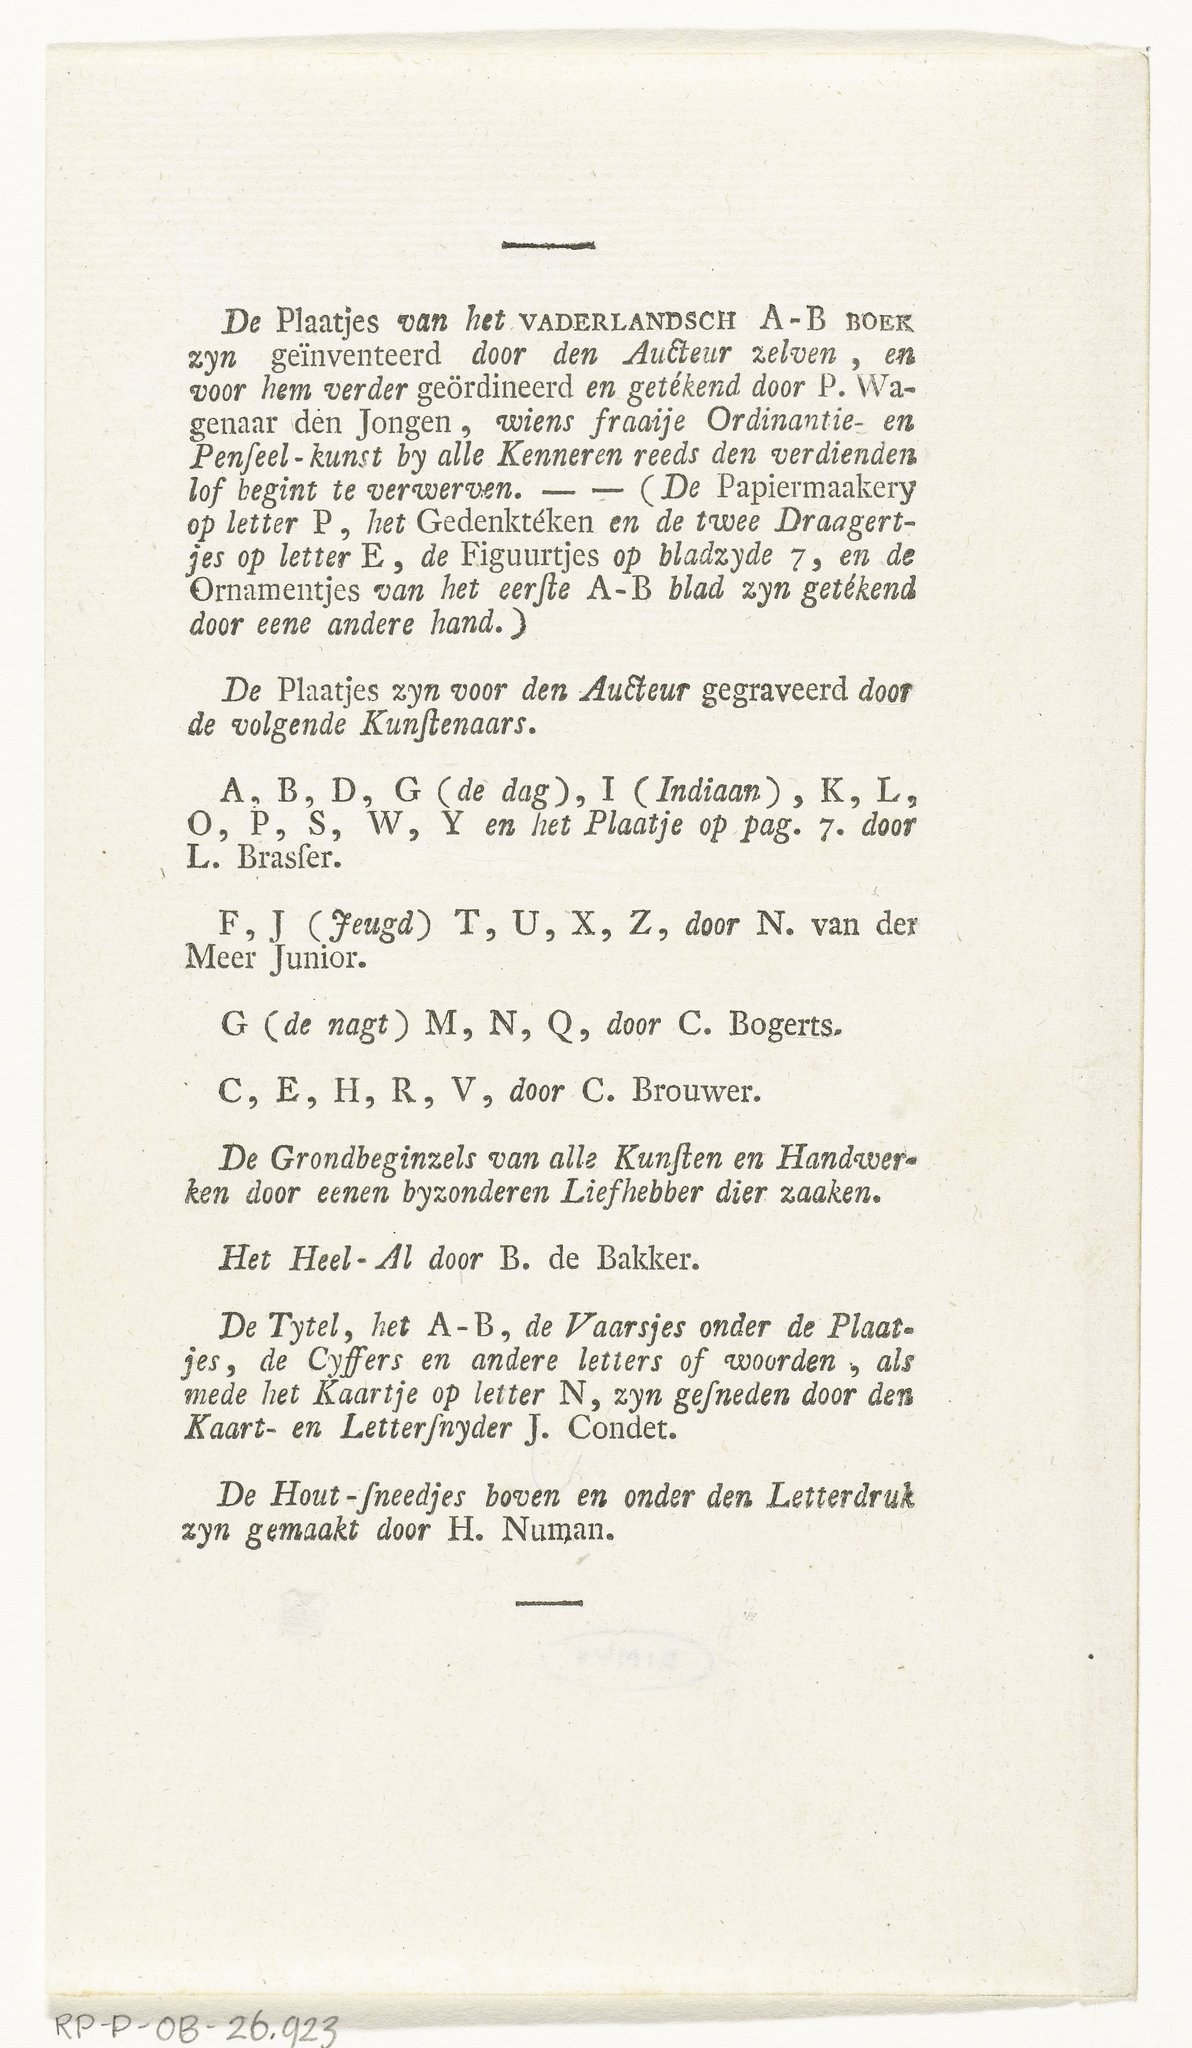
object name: text sheet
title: Tekstblad uit: Johan Hendrik Swildens, Vaderlandsch A-B boek, Amsterdam 1781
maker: willem holtrop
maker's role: publisher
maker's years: 1751-1835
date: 1781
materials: paper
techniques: letterpress printing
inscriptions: collector's mark: Lugt 2228, collector's mark: Lugt 2760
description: Tekstblad uit: Johan Hendrik Swildens, Vaderlandsch A-B boek, Amsterdam, uitgever W.Holtrop, 1781